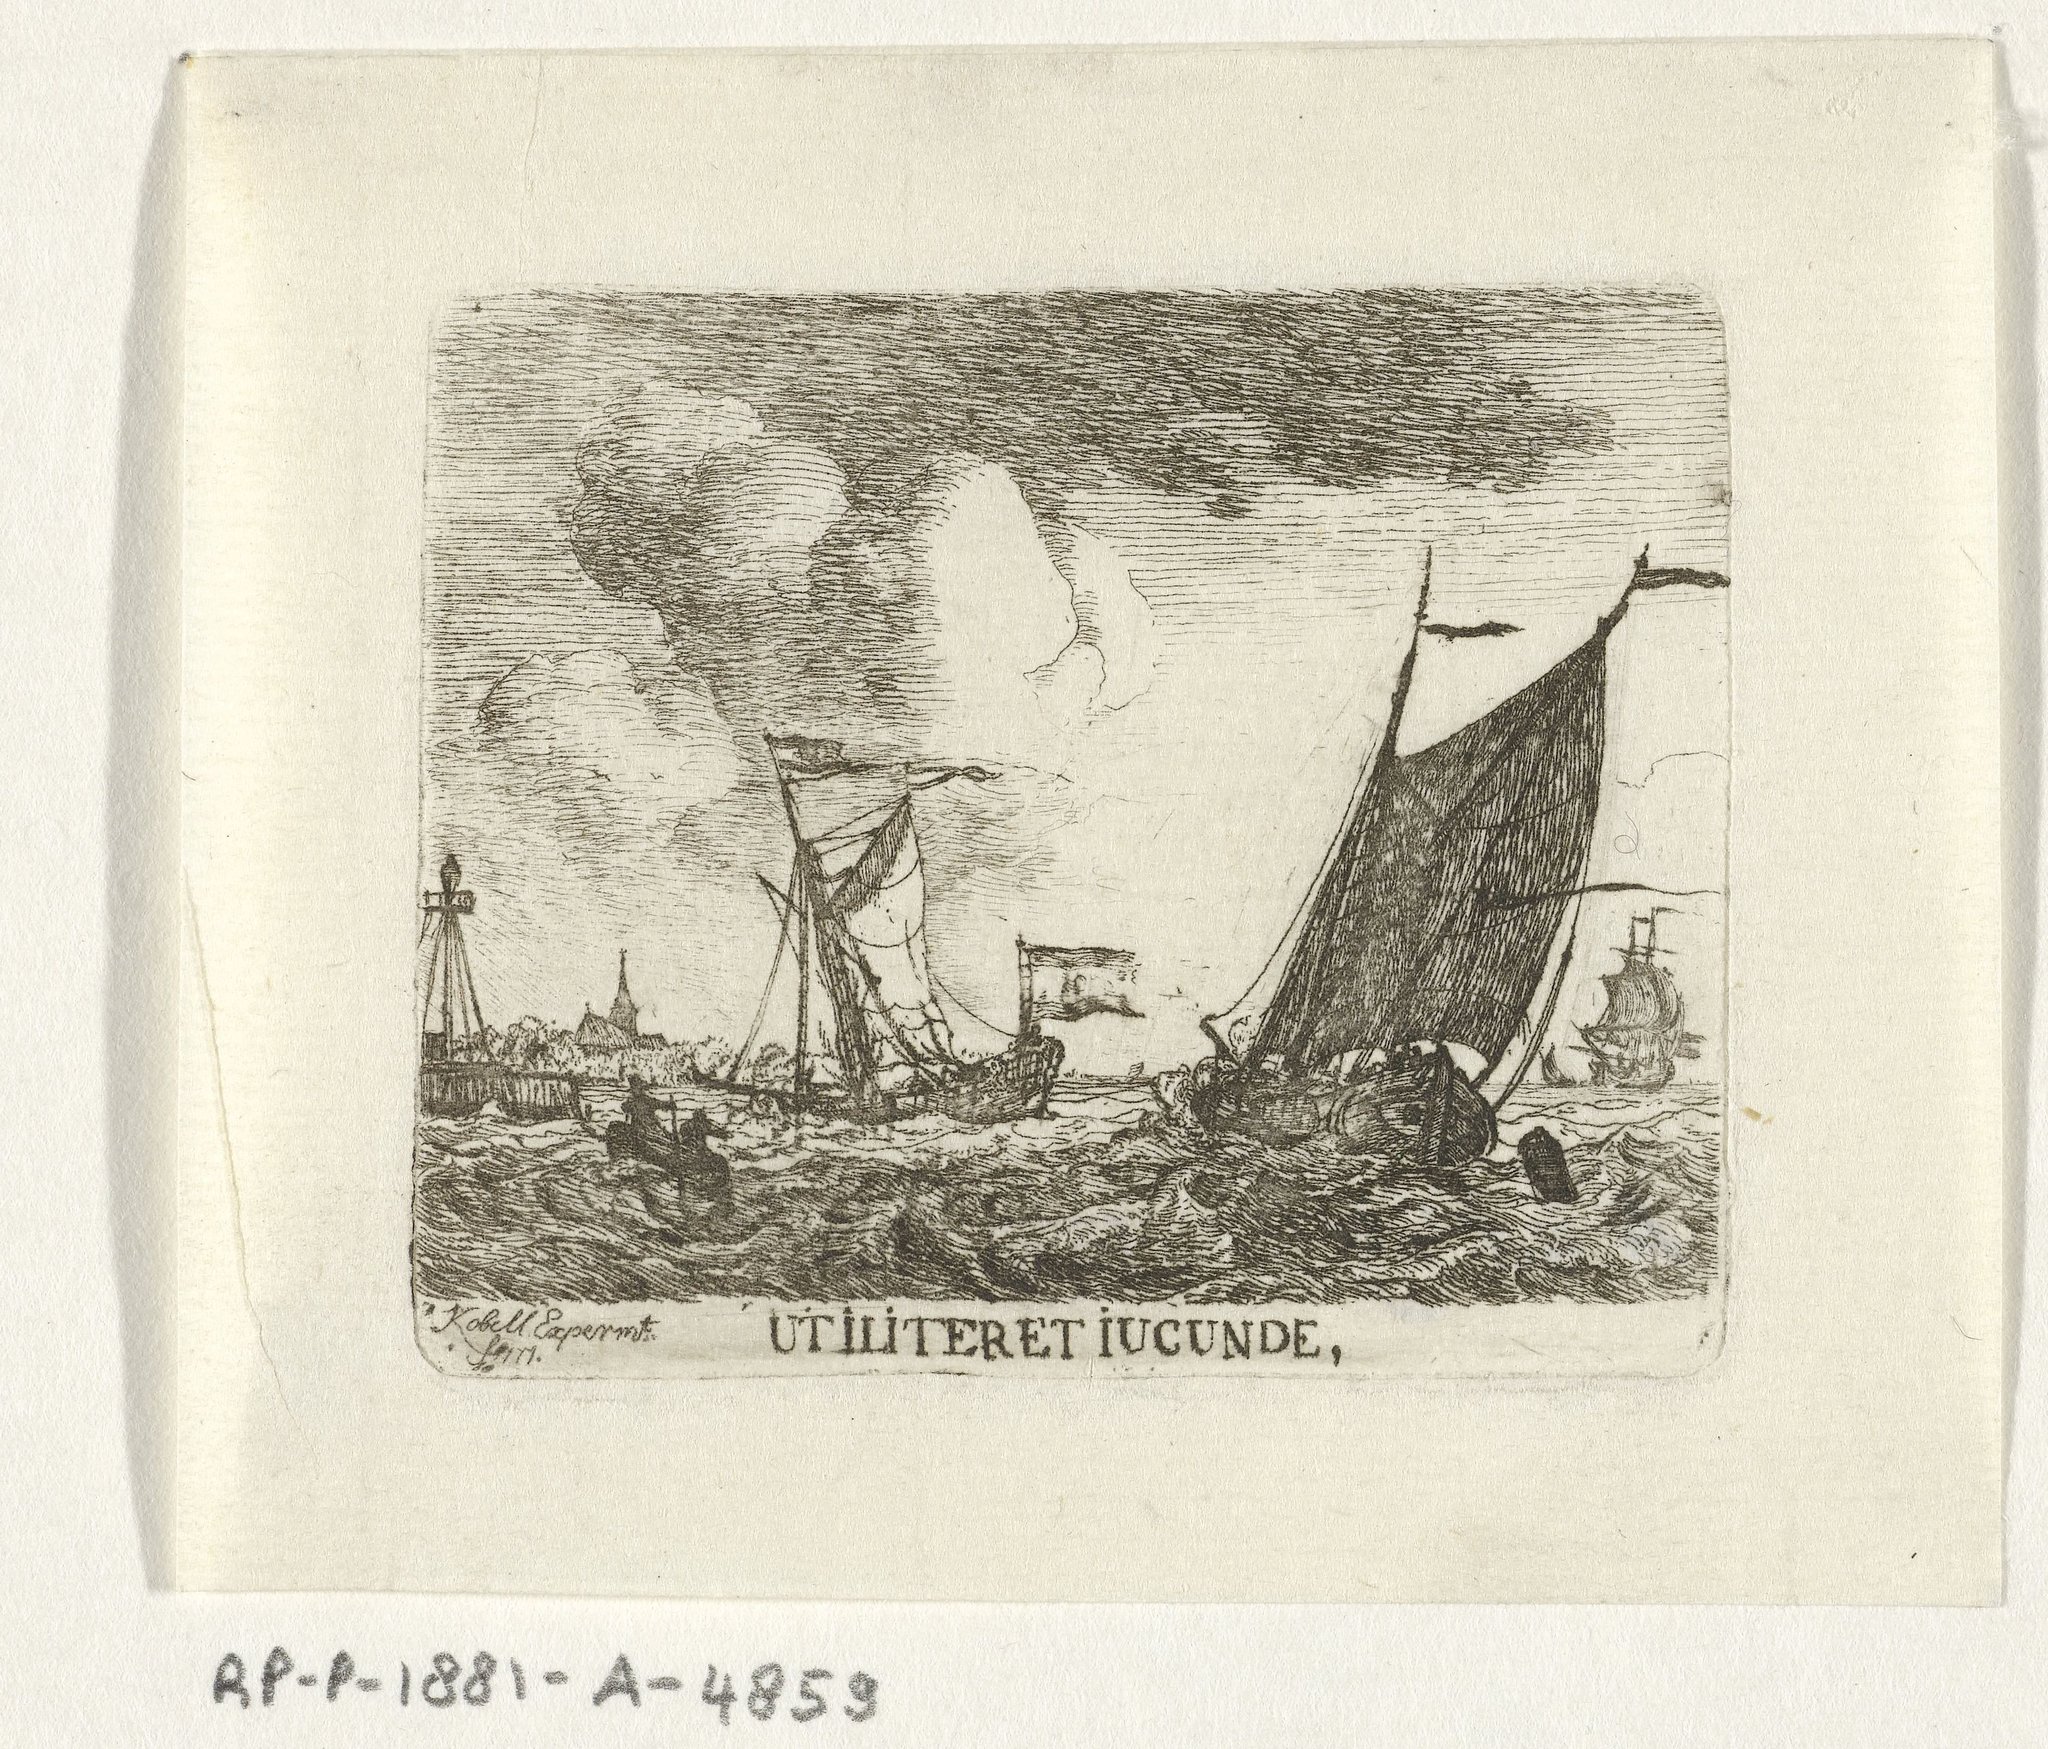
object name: print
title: Utiliter et Jucunde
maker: hendrik kobell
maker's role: draughtsman, painter, print maker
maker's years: 1751-1779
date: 1777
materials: paper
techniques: etching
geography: rotterdam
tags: sailing-ship, sailing-boat, church (exterior), rowing-boat, canoe, etc.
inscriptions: collector's mark: Lugt 2227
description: Riviergezicht met drie zeilschepen op woelig water. Links de contouren van een stad met de kerk en het havenhoofd en daarvoor een roeibootje met daarin twee figuren.